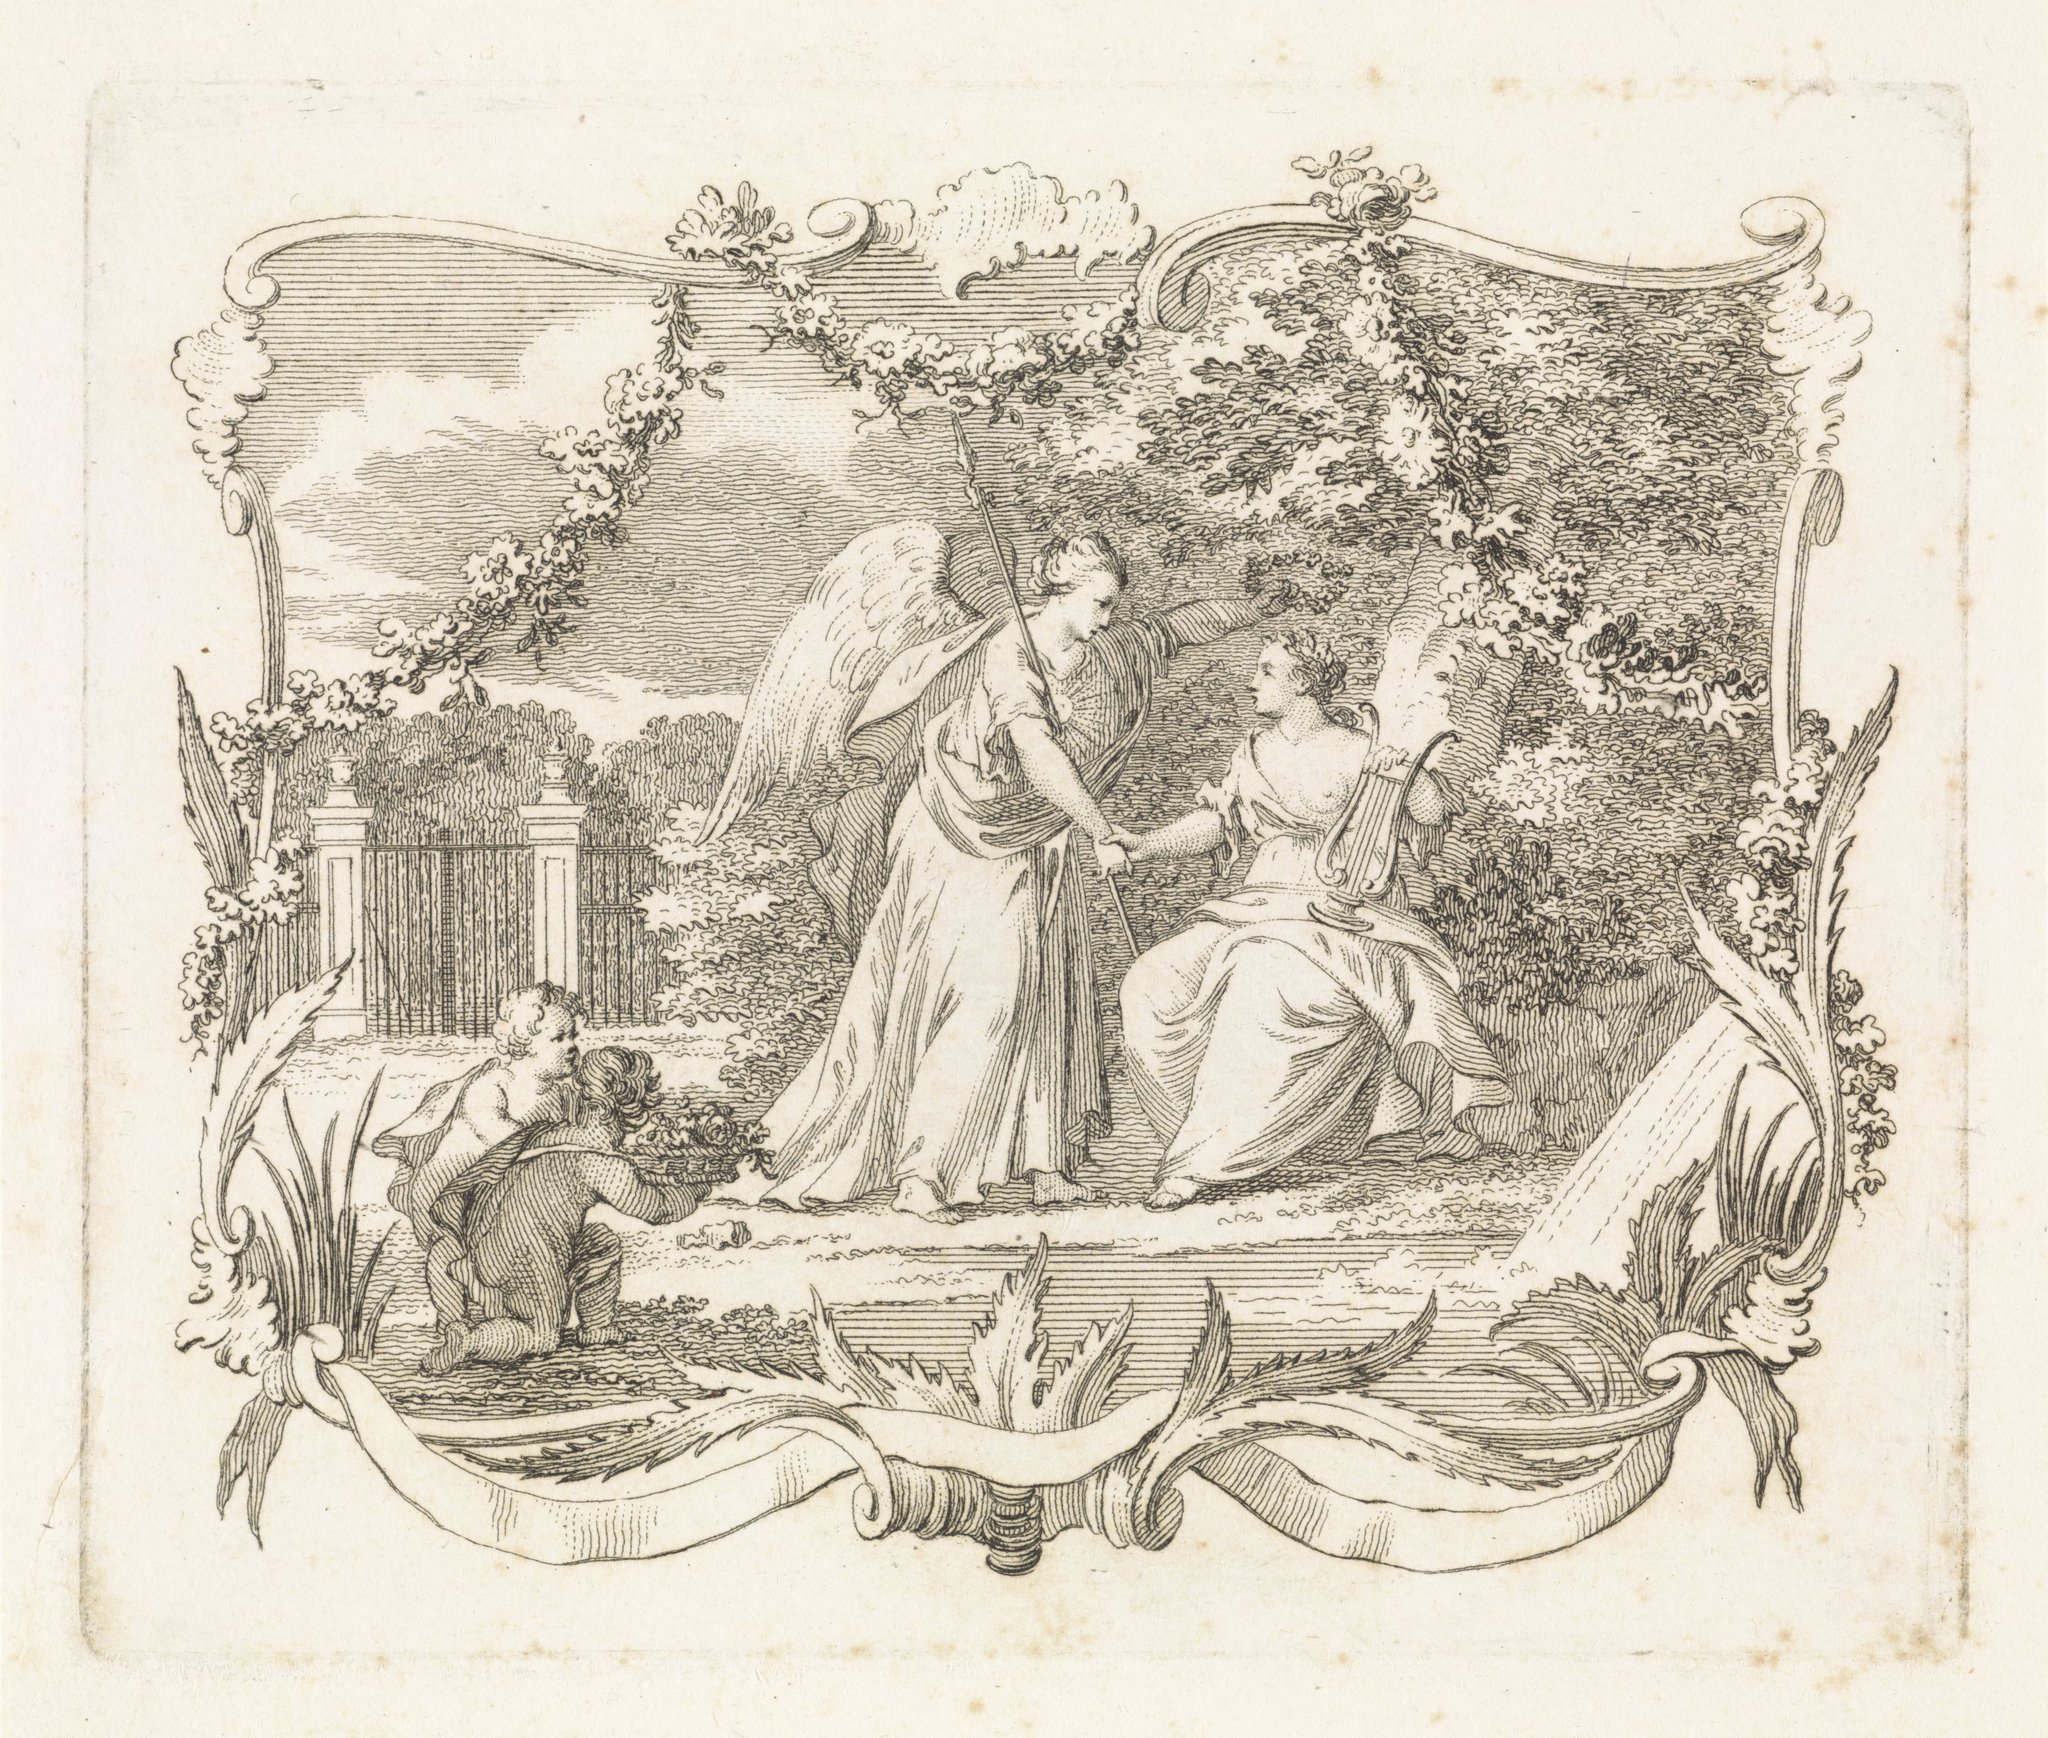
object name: print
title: Allegorie op de dichtkunst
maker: reinier vinkeles (i)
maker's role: draughtsman, print maker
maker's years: 1741-1816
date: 1768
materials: paper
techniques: etching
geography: amsterdam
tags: symbolic representations, allegories and emblems ~ poetry; 'poesia' (ripa), cupids: 'amores', 'amoretti', 'putti', angels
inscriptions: collector's mark: Lugt 240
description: Onder een boom bespeelt een vrouwelijk personificatie van de Poëzie een lier. Ze wordt door een engel gekroond. Op de voorgrond twee geknielde putti met een schaal bloemen.